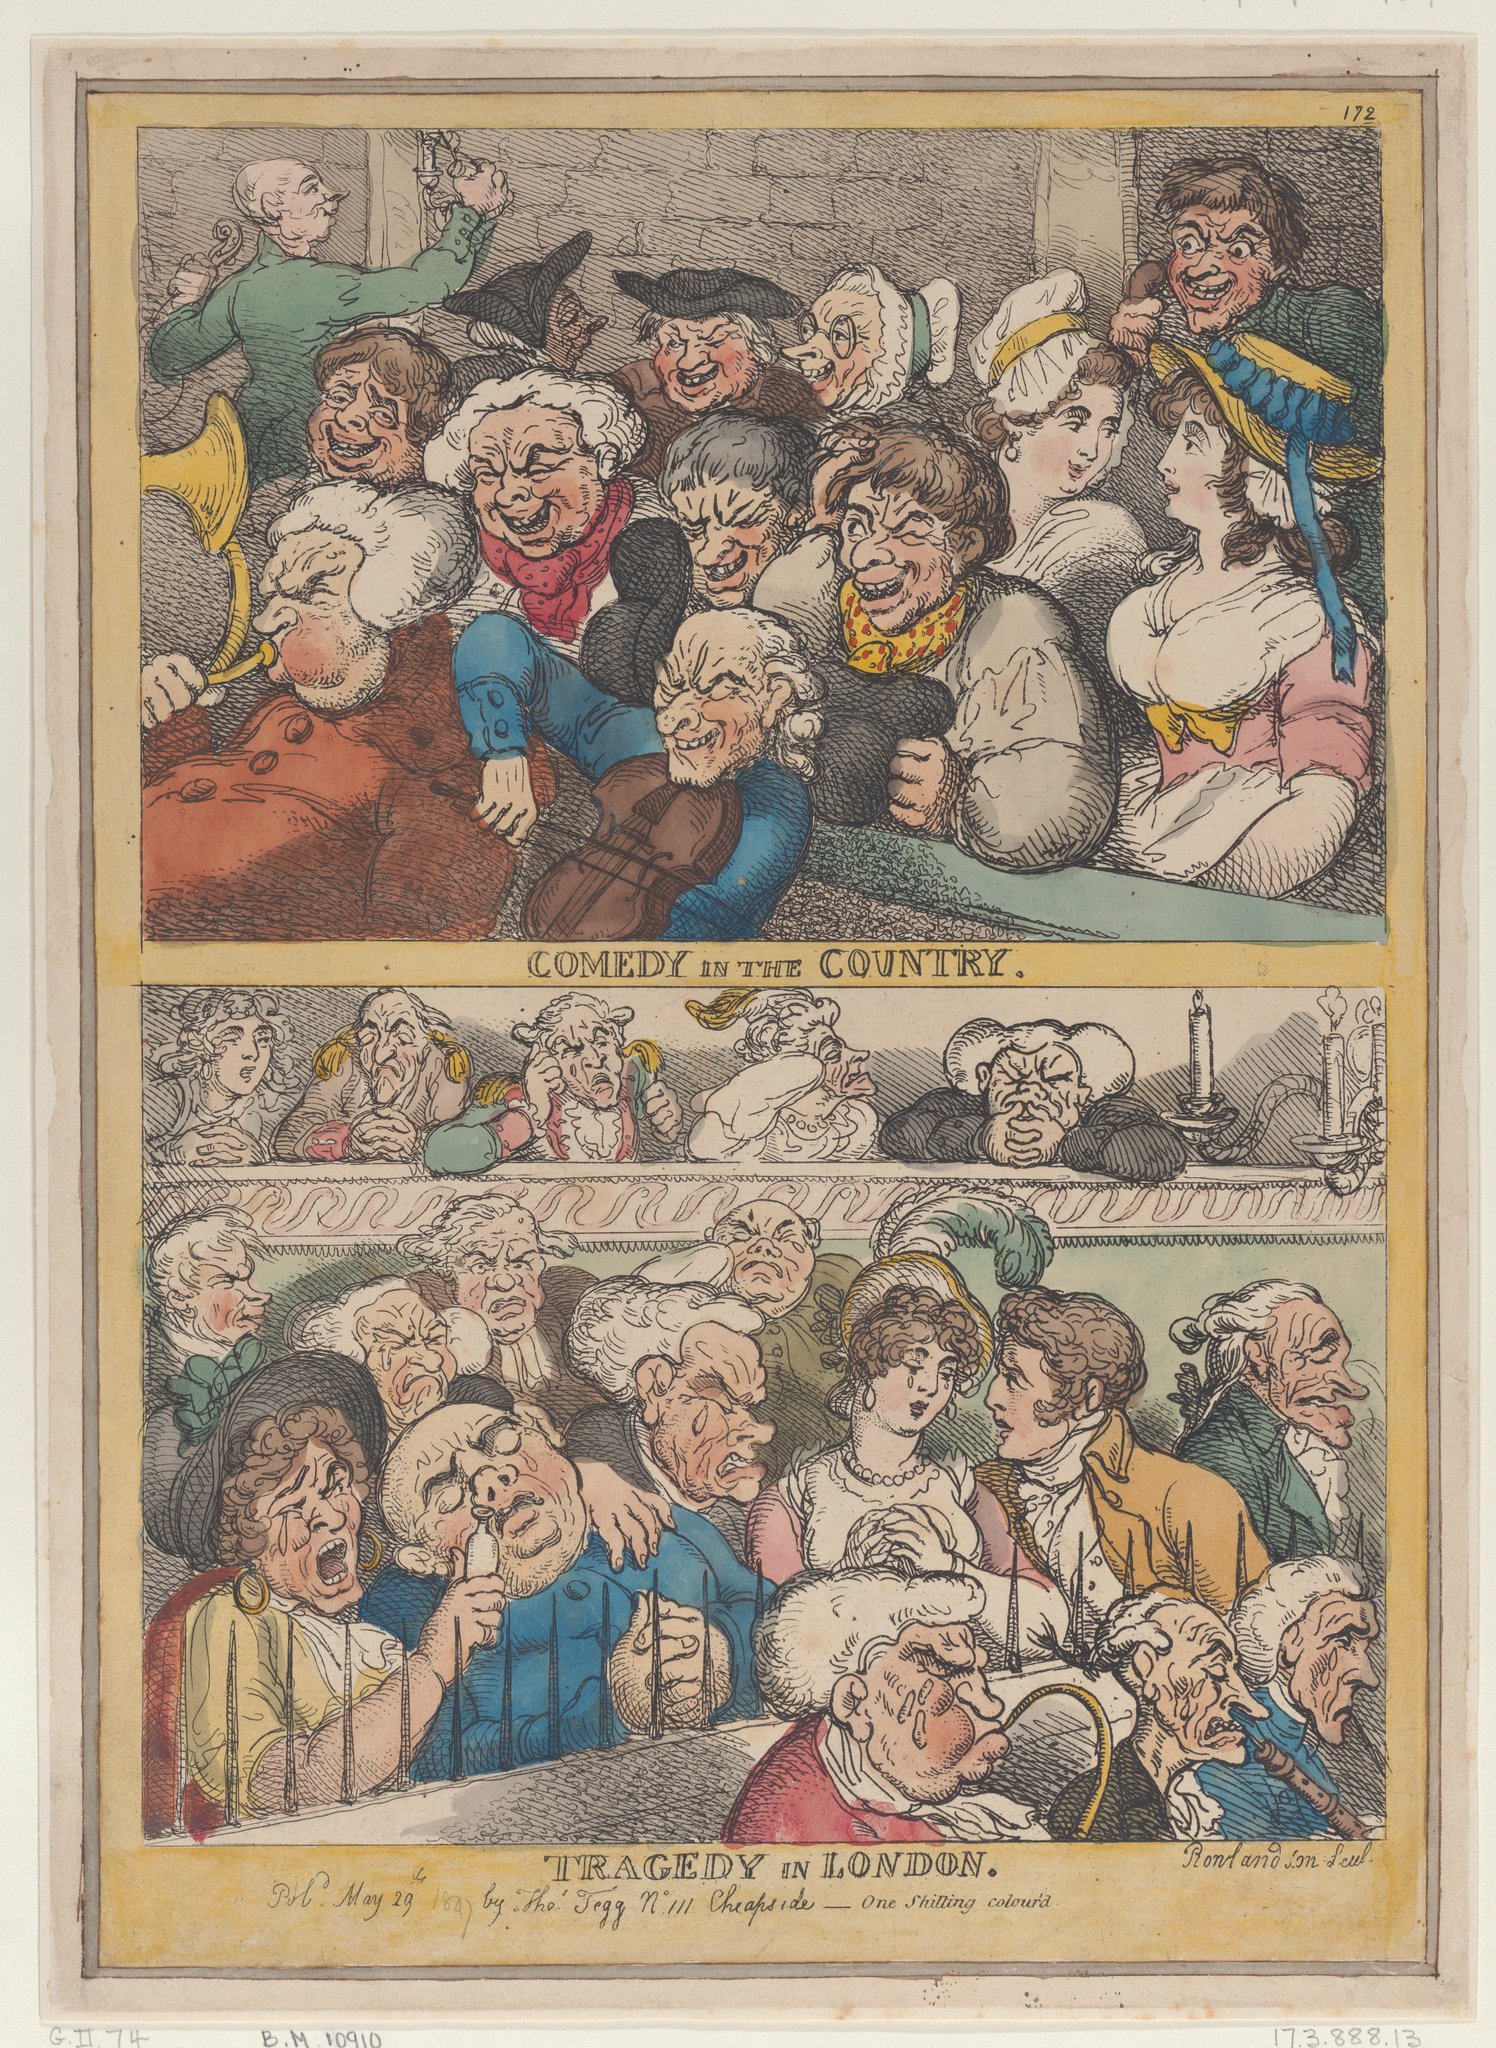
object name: print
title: Comedy in the Country, Tragedy in London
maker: thomas rowlandson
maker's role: artist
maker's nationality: british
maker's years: 1757-1827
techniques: etching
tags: satire,men,women,spectators